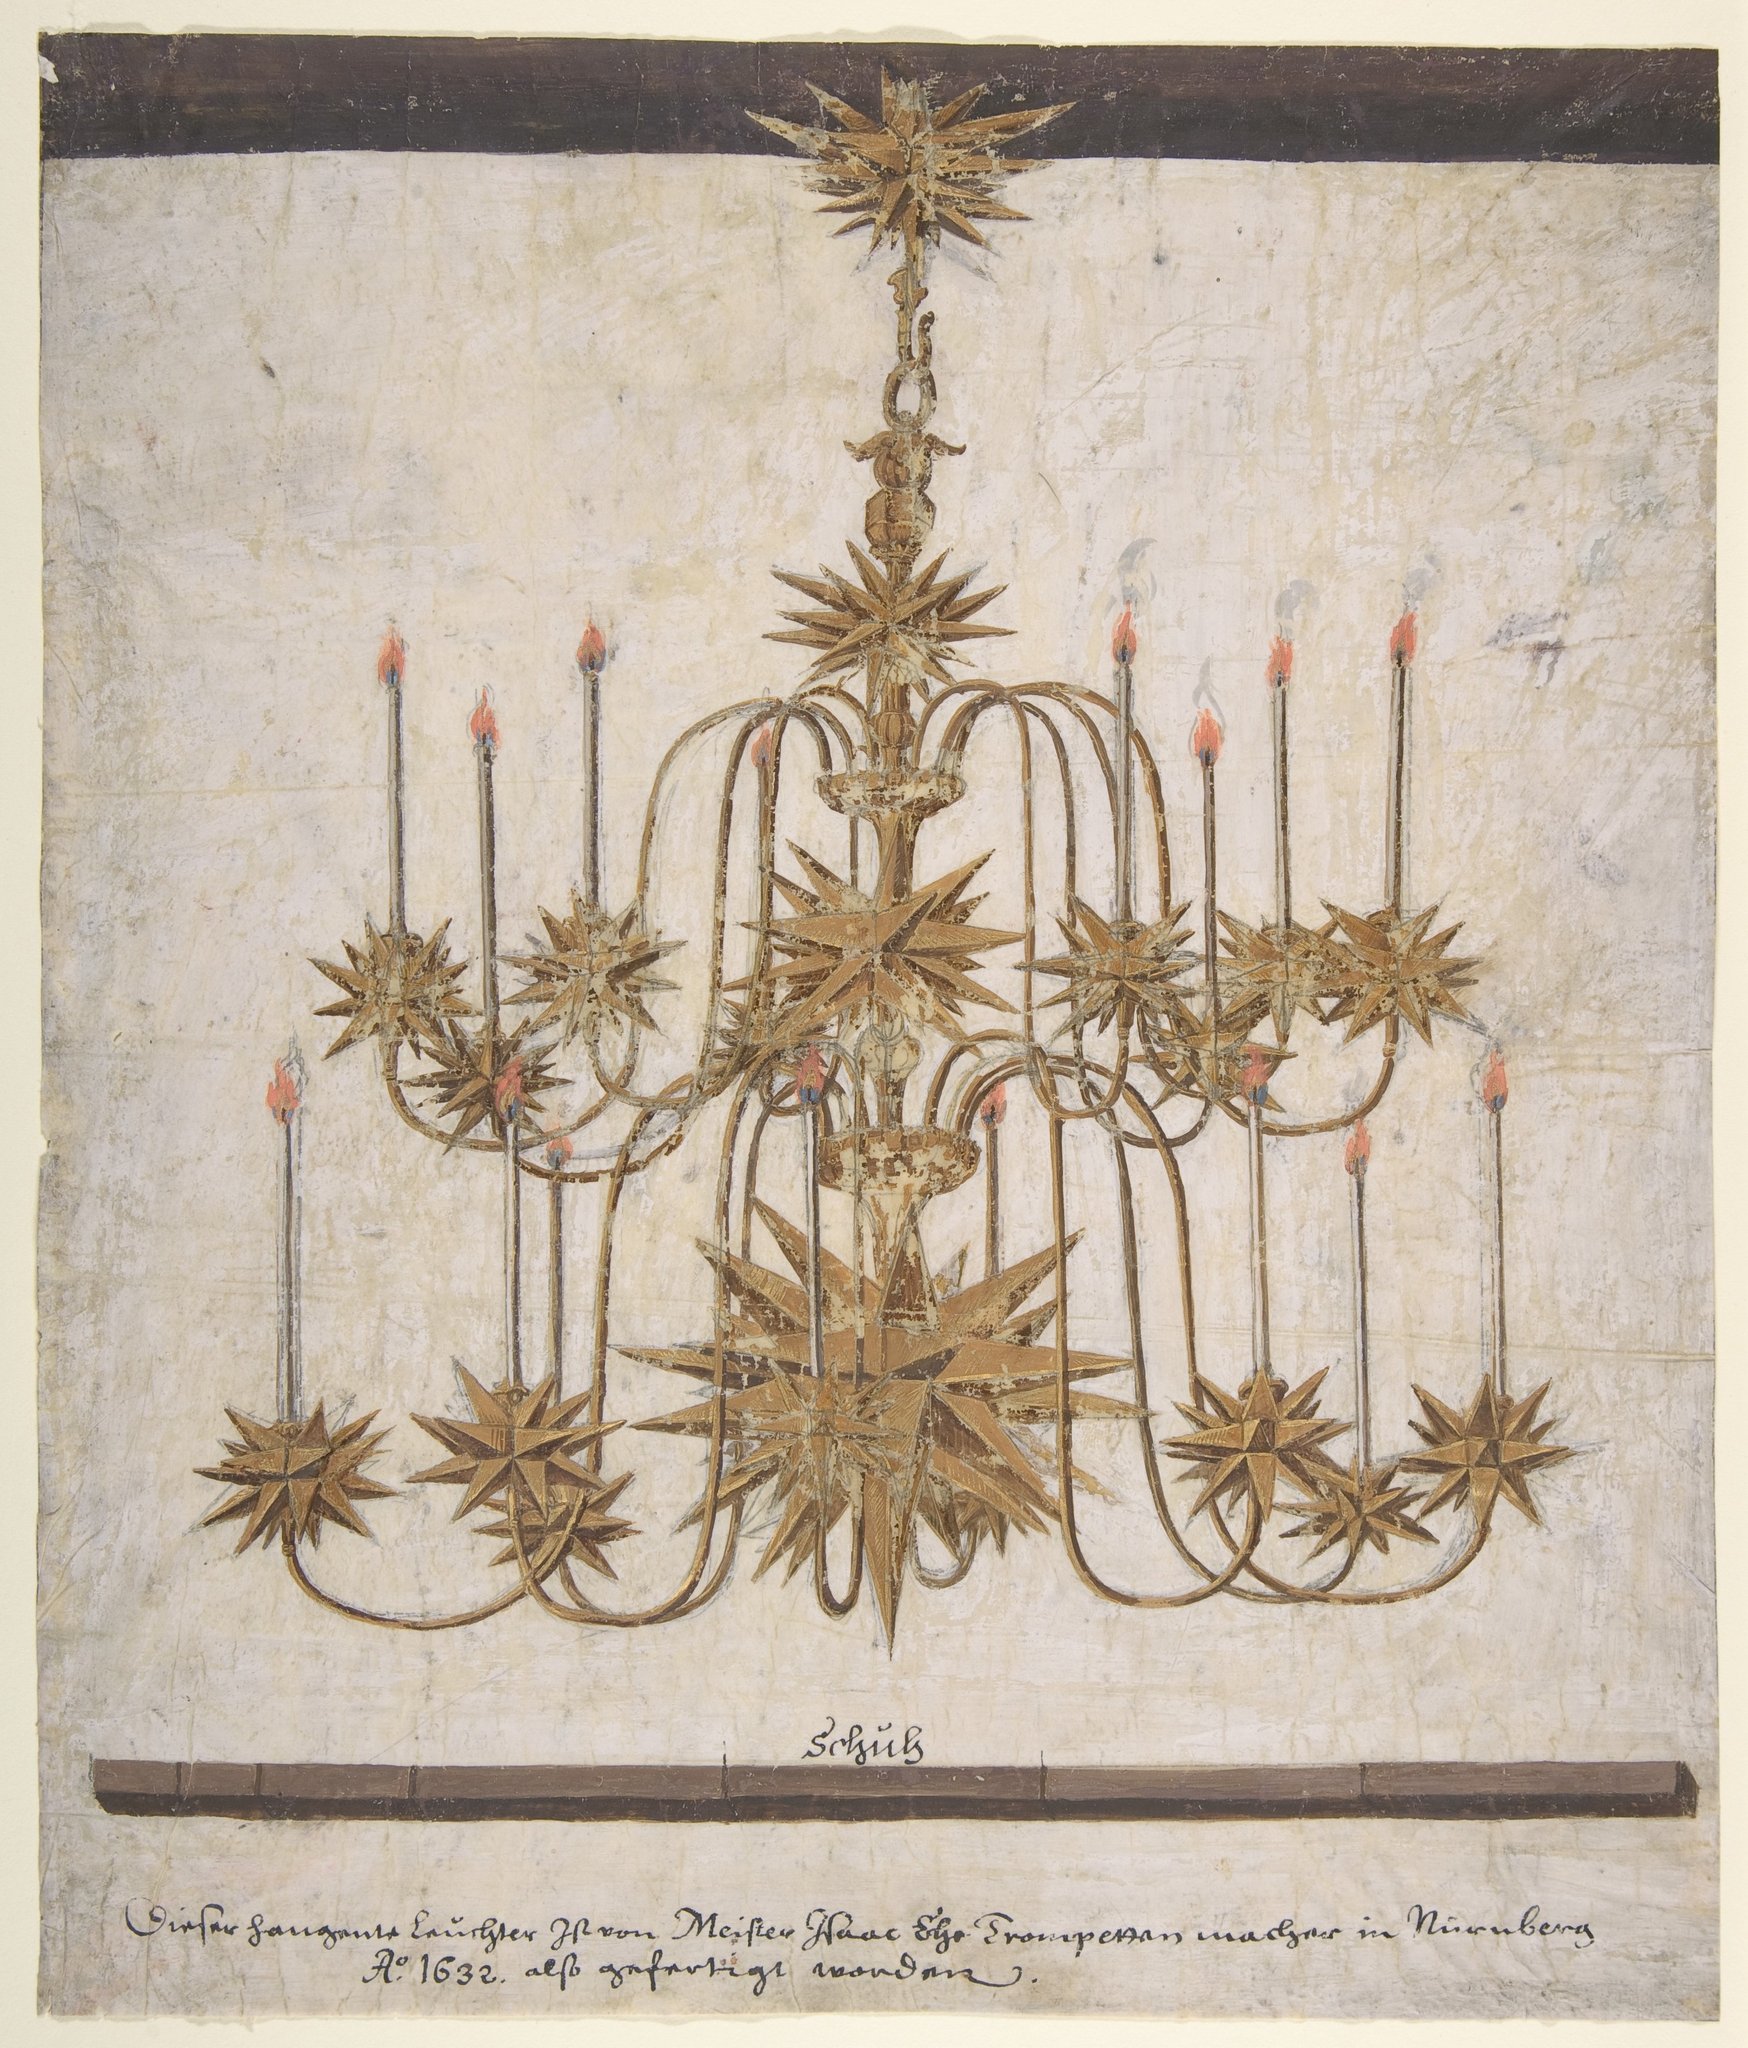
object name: drawing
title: Design for a Chandelier with Sixteen Candles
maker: isaak ehe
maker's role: artist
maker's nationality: german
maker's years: 1586-1632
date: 1632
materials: gold paint, gouache, parchment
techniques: brush